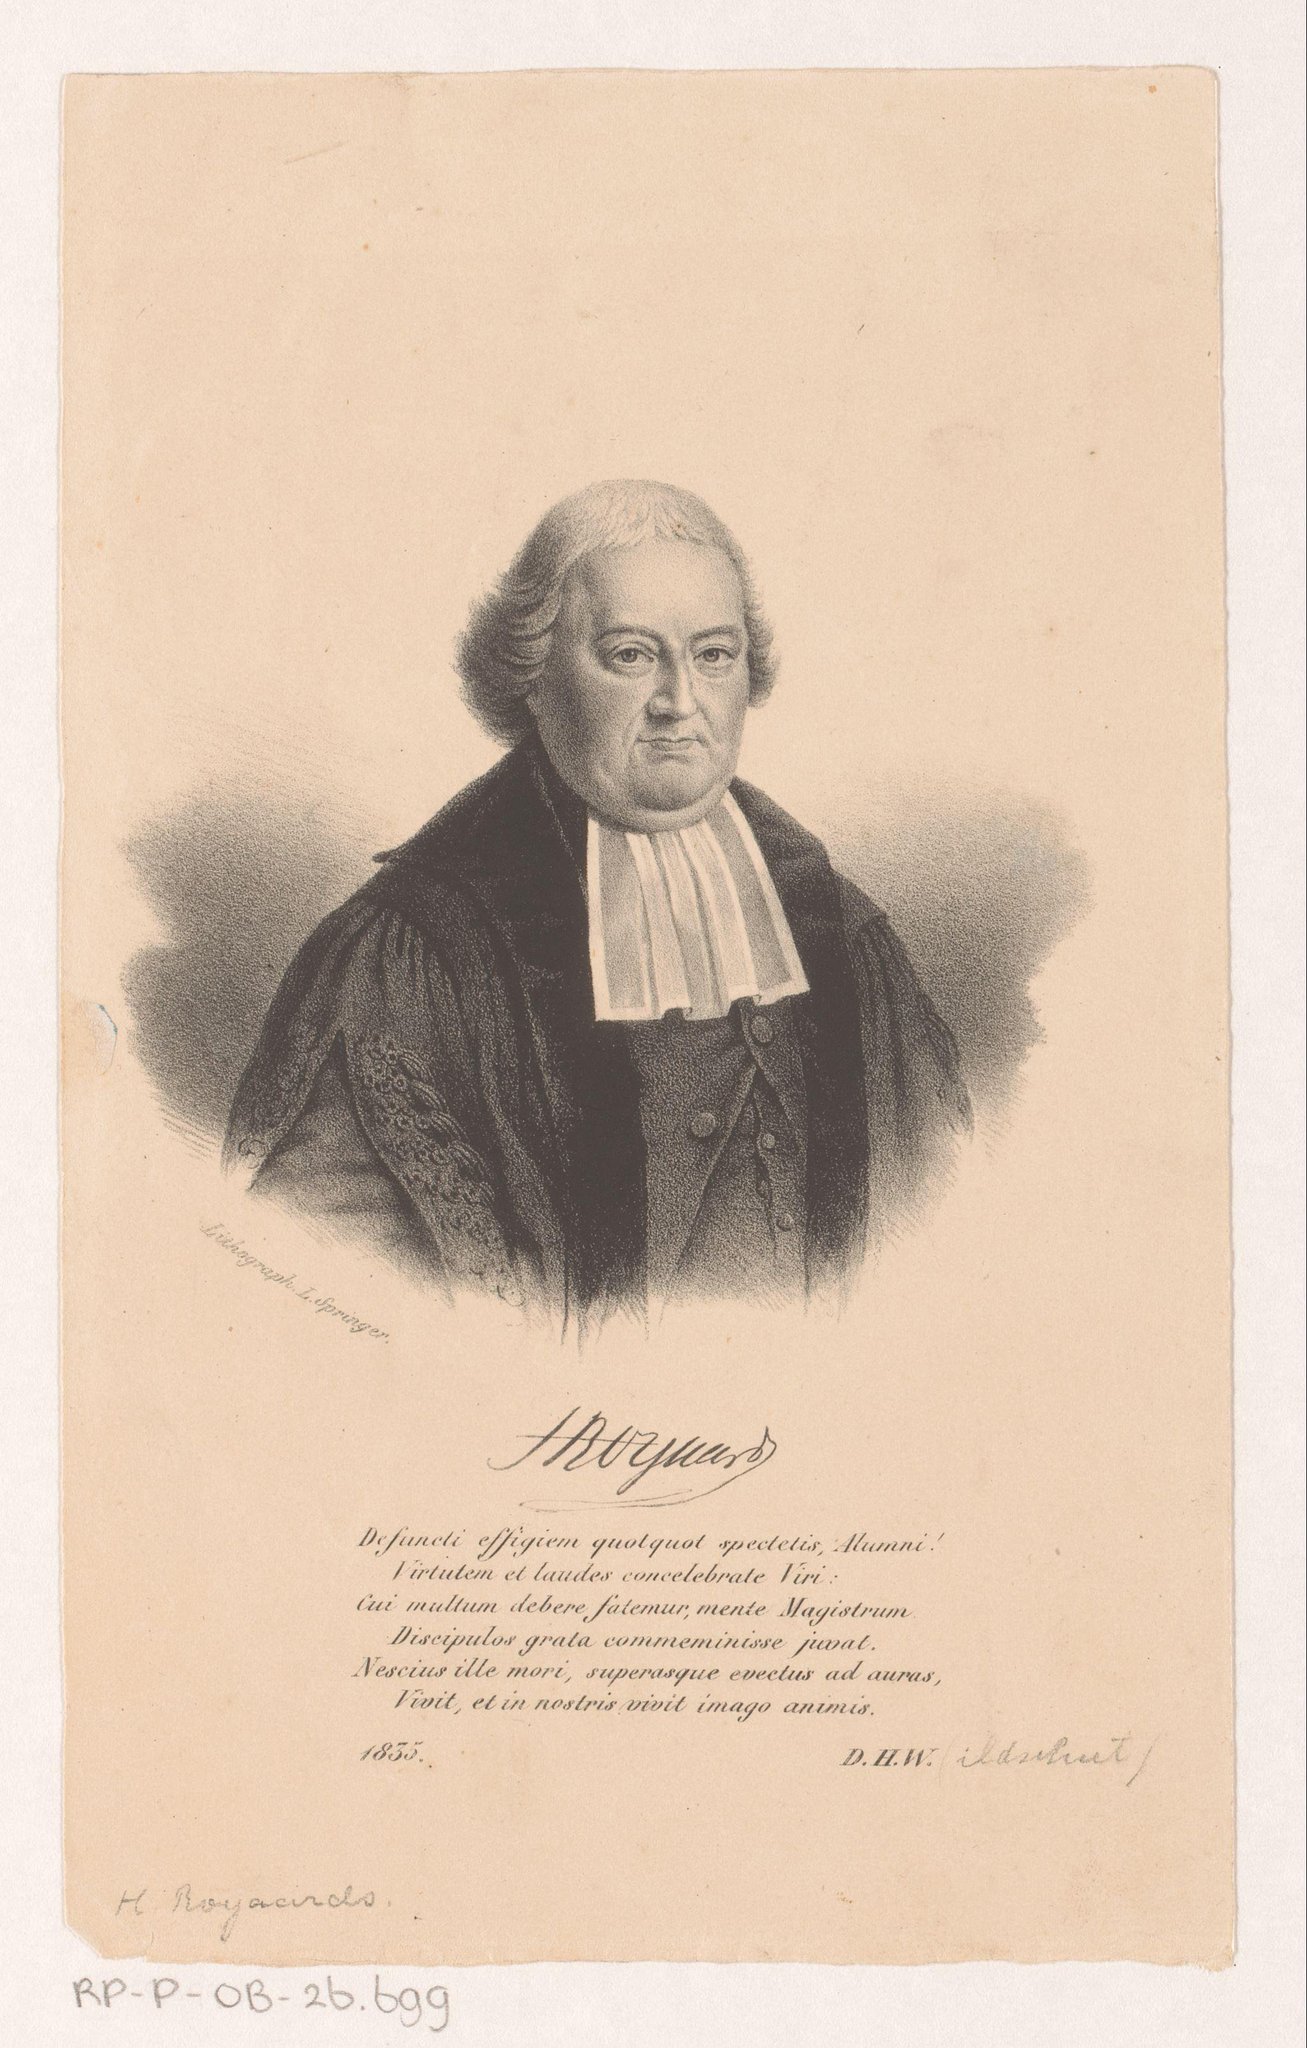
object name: print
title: Portret van Hermannus Royaards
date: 1835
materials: paper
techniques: lithograph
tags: utrecht, historical persons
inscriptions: collector's mark: Lugt 2228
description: Onder het portret de signatuur van de geportretteerde en een zesregelig Latijns vers van D.H. Wildschut.